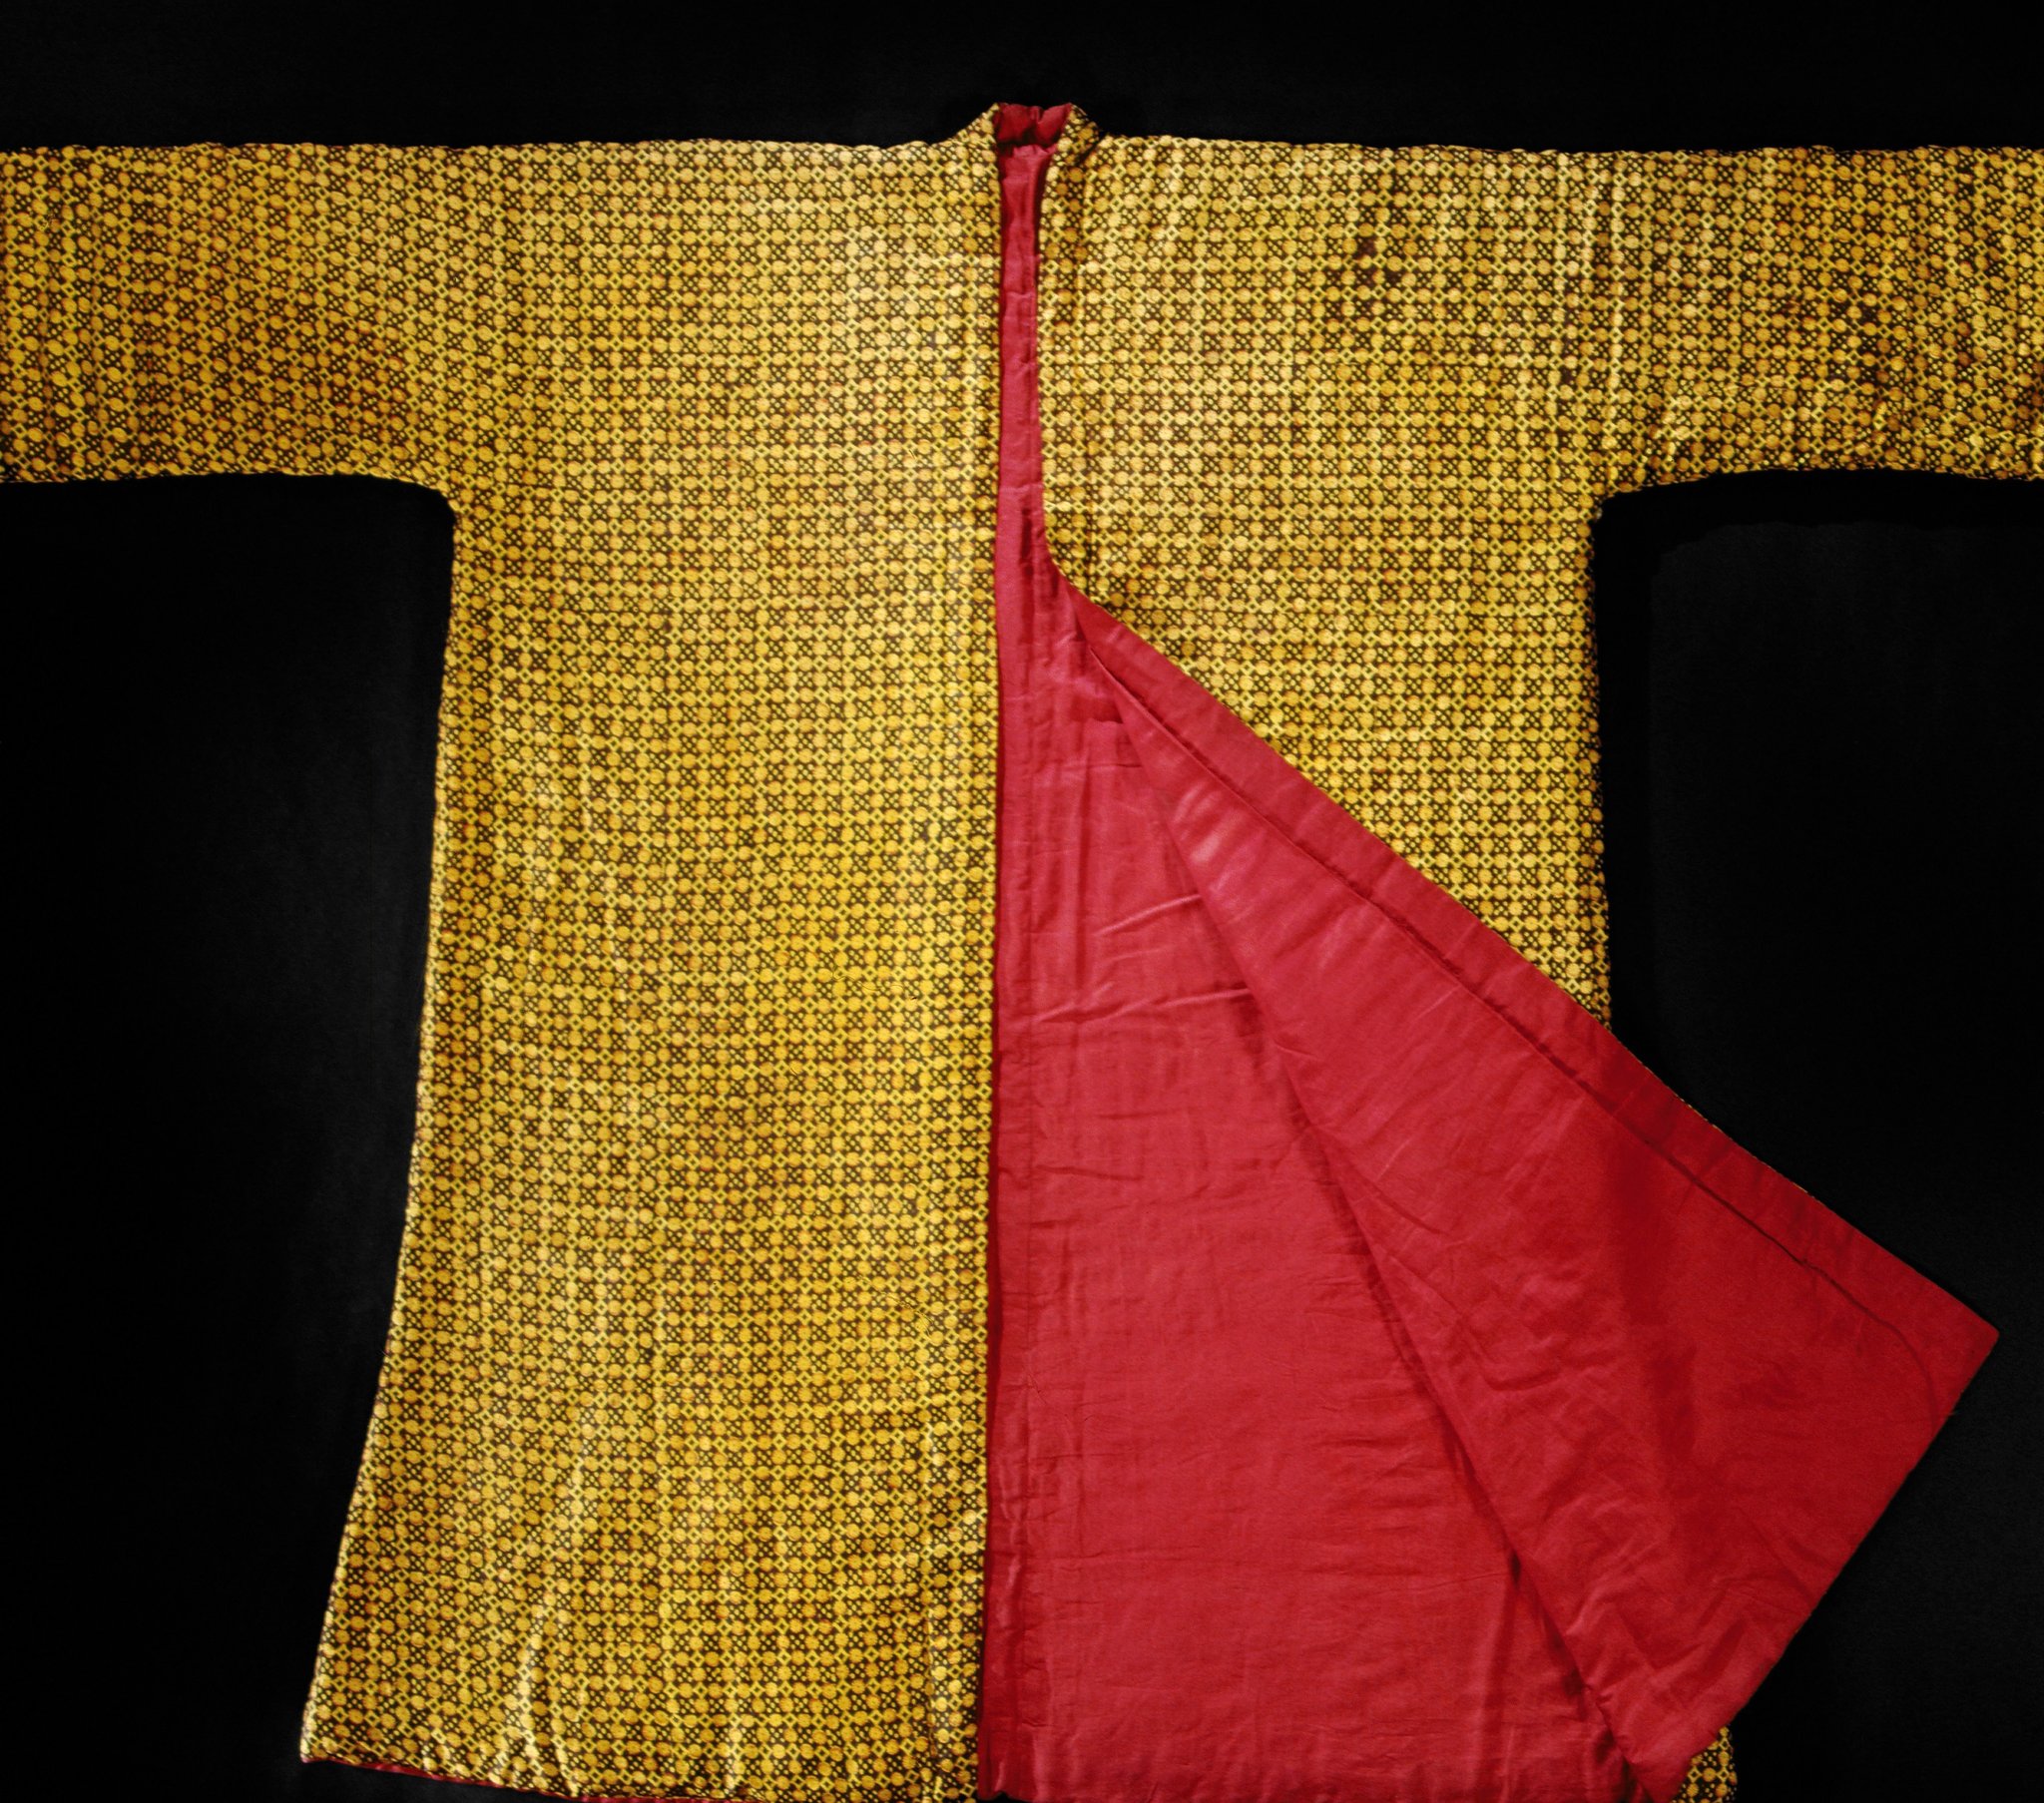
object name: kabaai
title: Huisjas van bedrukte zijde, gewatteerd en gevoerd met rode zijde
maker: Anonymous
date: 1690-1700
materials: silk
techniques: printing block, weave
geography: bengal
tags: amsterdam, jonkheer jan six, painter, gijs bosch reitz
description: Op 20 maart 1925 droeg prof. jhr. dr. Jan Six deze jas als 'Argan' (Moliere, 'Malade Imaginaire') naar het Casinobal, dat op de Keizersgracht 464 werd gehouden. Hij droeg hierbij de 18de eeuwse linnenbatisten slaapmuts (BK-1978-..). Zie foto van Six, Collectie Six Amsterdam, inv. ?. De jas was echter in het bezit van Six's zwager, S.C. Bosch Reitz, die op dat moment in New York woonachtig was. Hij schrijft hierover het volgende: 'The Century Association/ 7 west forty-third street/ New York 25 maart 1925/ Waarde Jan, Dat je de chamberlouk op het gecoste bal draagt vind ik heel best , het idee is heel gelukkig en zal zeker succes hebben, had ik geweten dat je als "de gewaande zieke" heenging zou ik je gezegd hebben dat ik een dag slaapmuts of kamermuts heb, het kopdeksel dat men droeg voor de pruik opgezet werd, van gebloemd gedrukt katoen. Het zou er goed bij gepast hebben, maar het is nu te laat.' (met pentekeningetje van huismuts BK-1978-792), Collectie Six Amsterdam, inv. 51531.